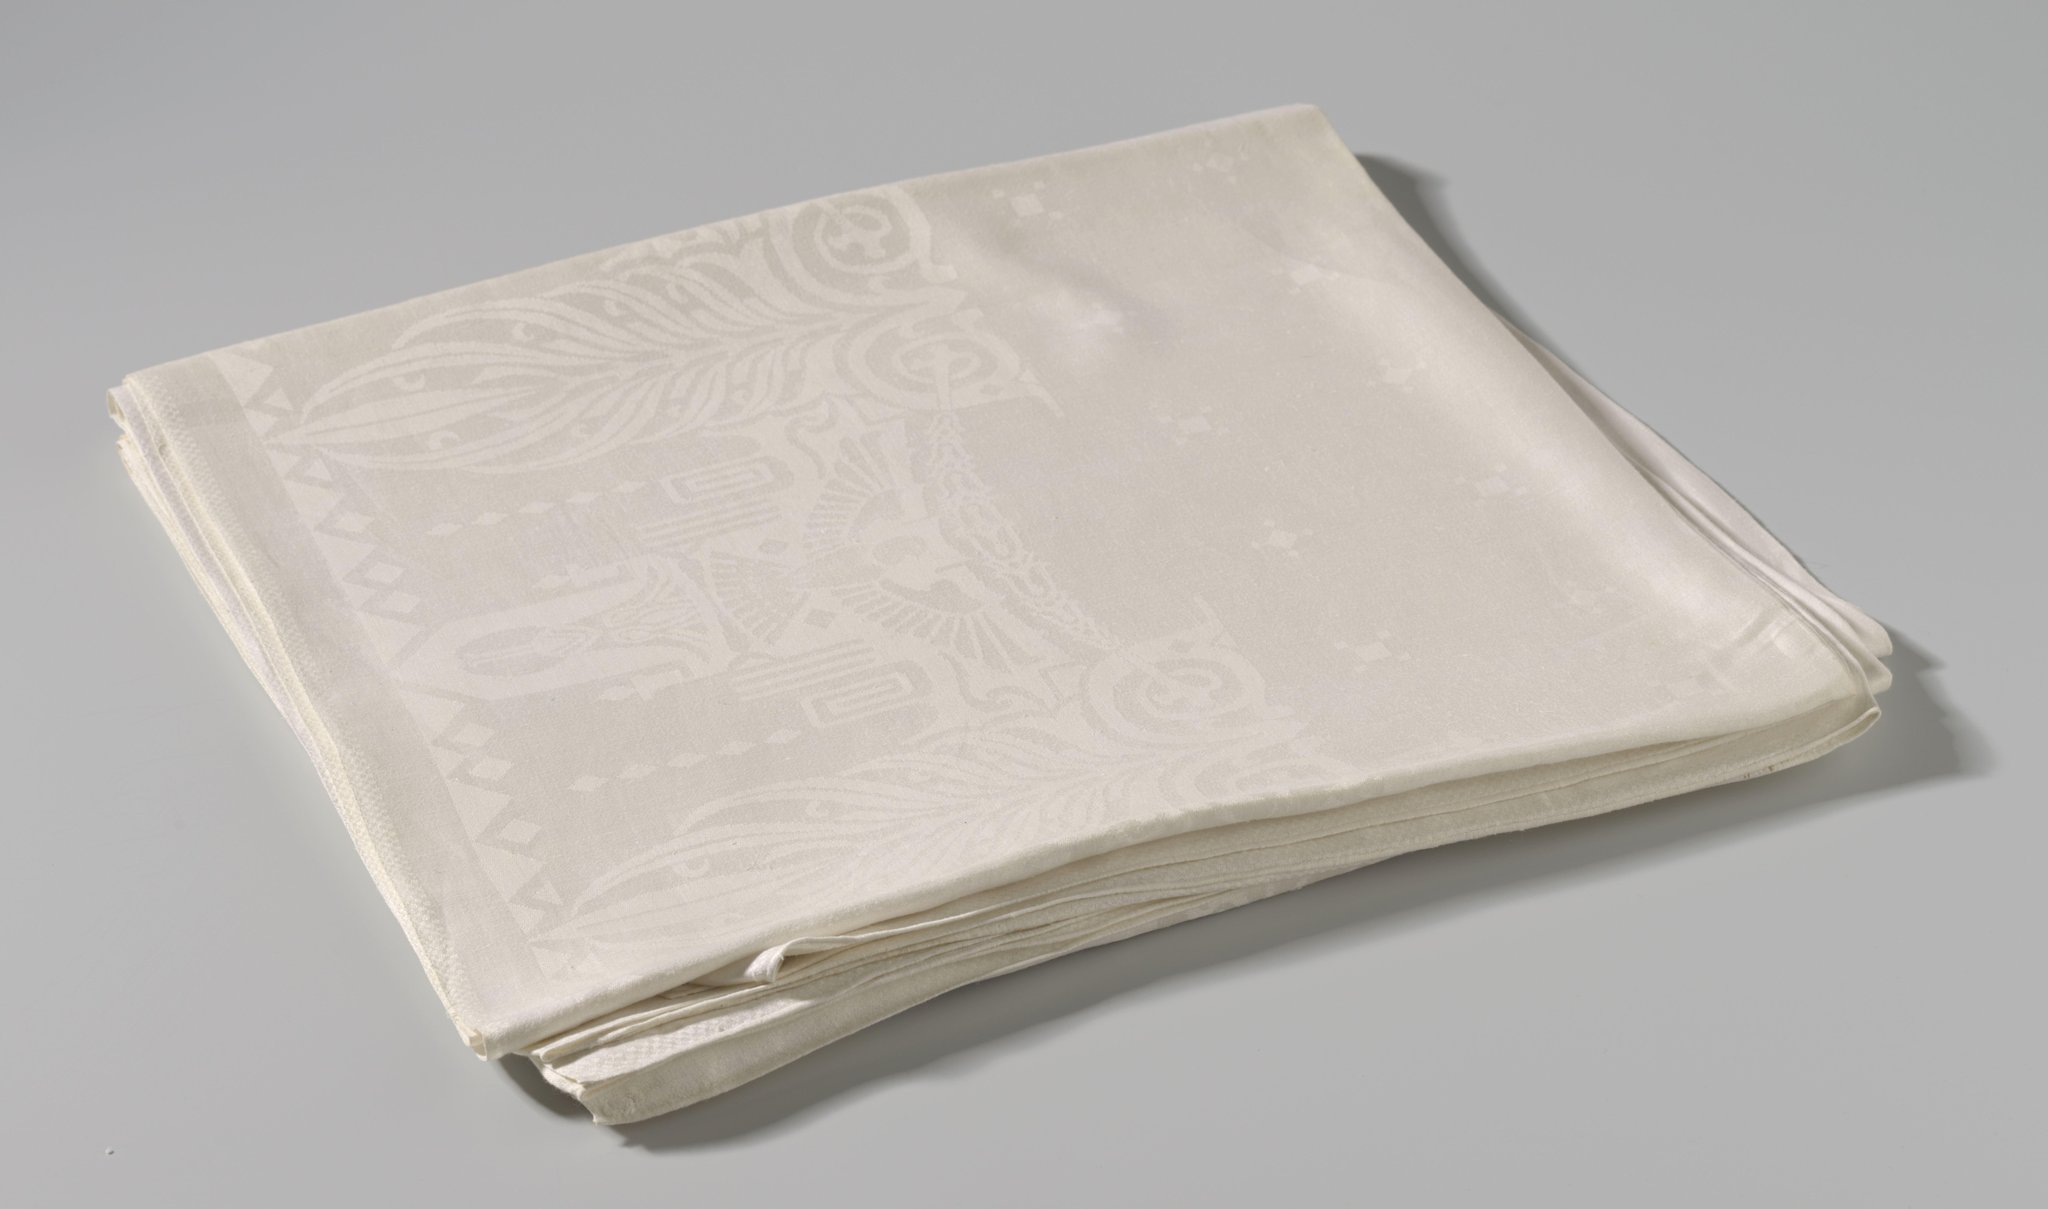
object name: tablecloth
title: Tafellaken van linnendamast met voorstelling Vrede Versailles, gedateerd 1919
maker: Anonymous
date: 1919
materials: linen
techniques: damask, weave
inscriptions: date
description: Tafellaken van linnendamast met de vrede van Versailles. De stijl is overgang Jugendstil-Art Deco. Het laken is gedateerd: 1919.